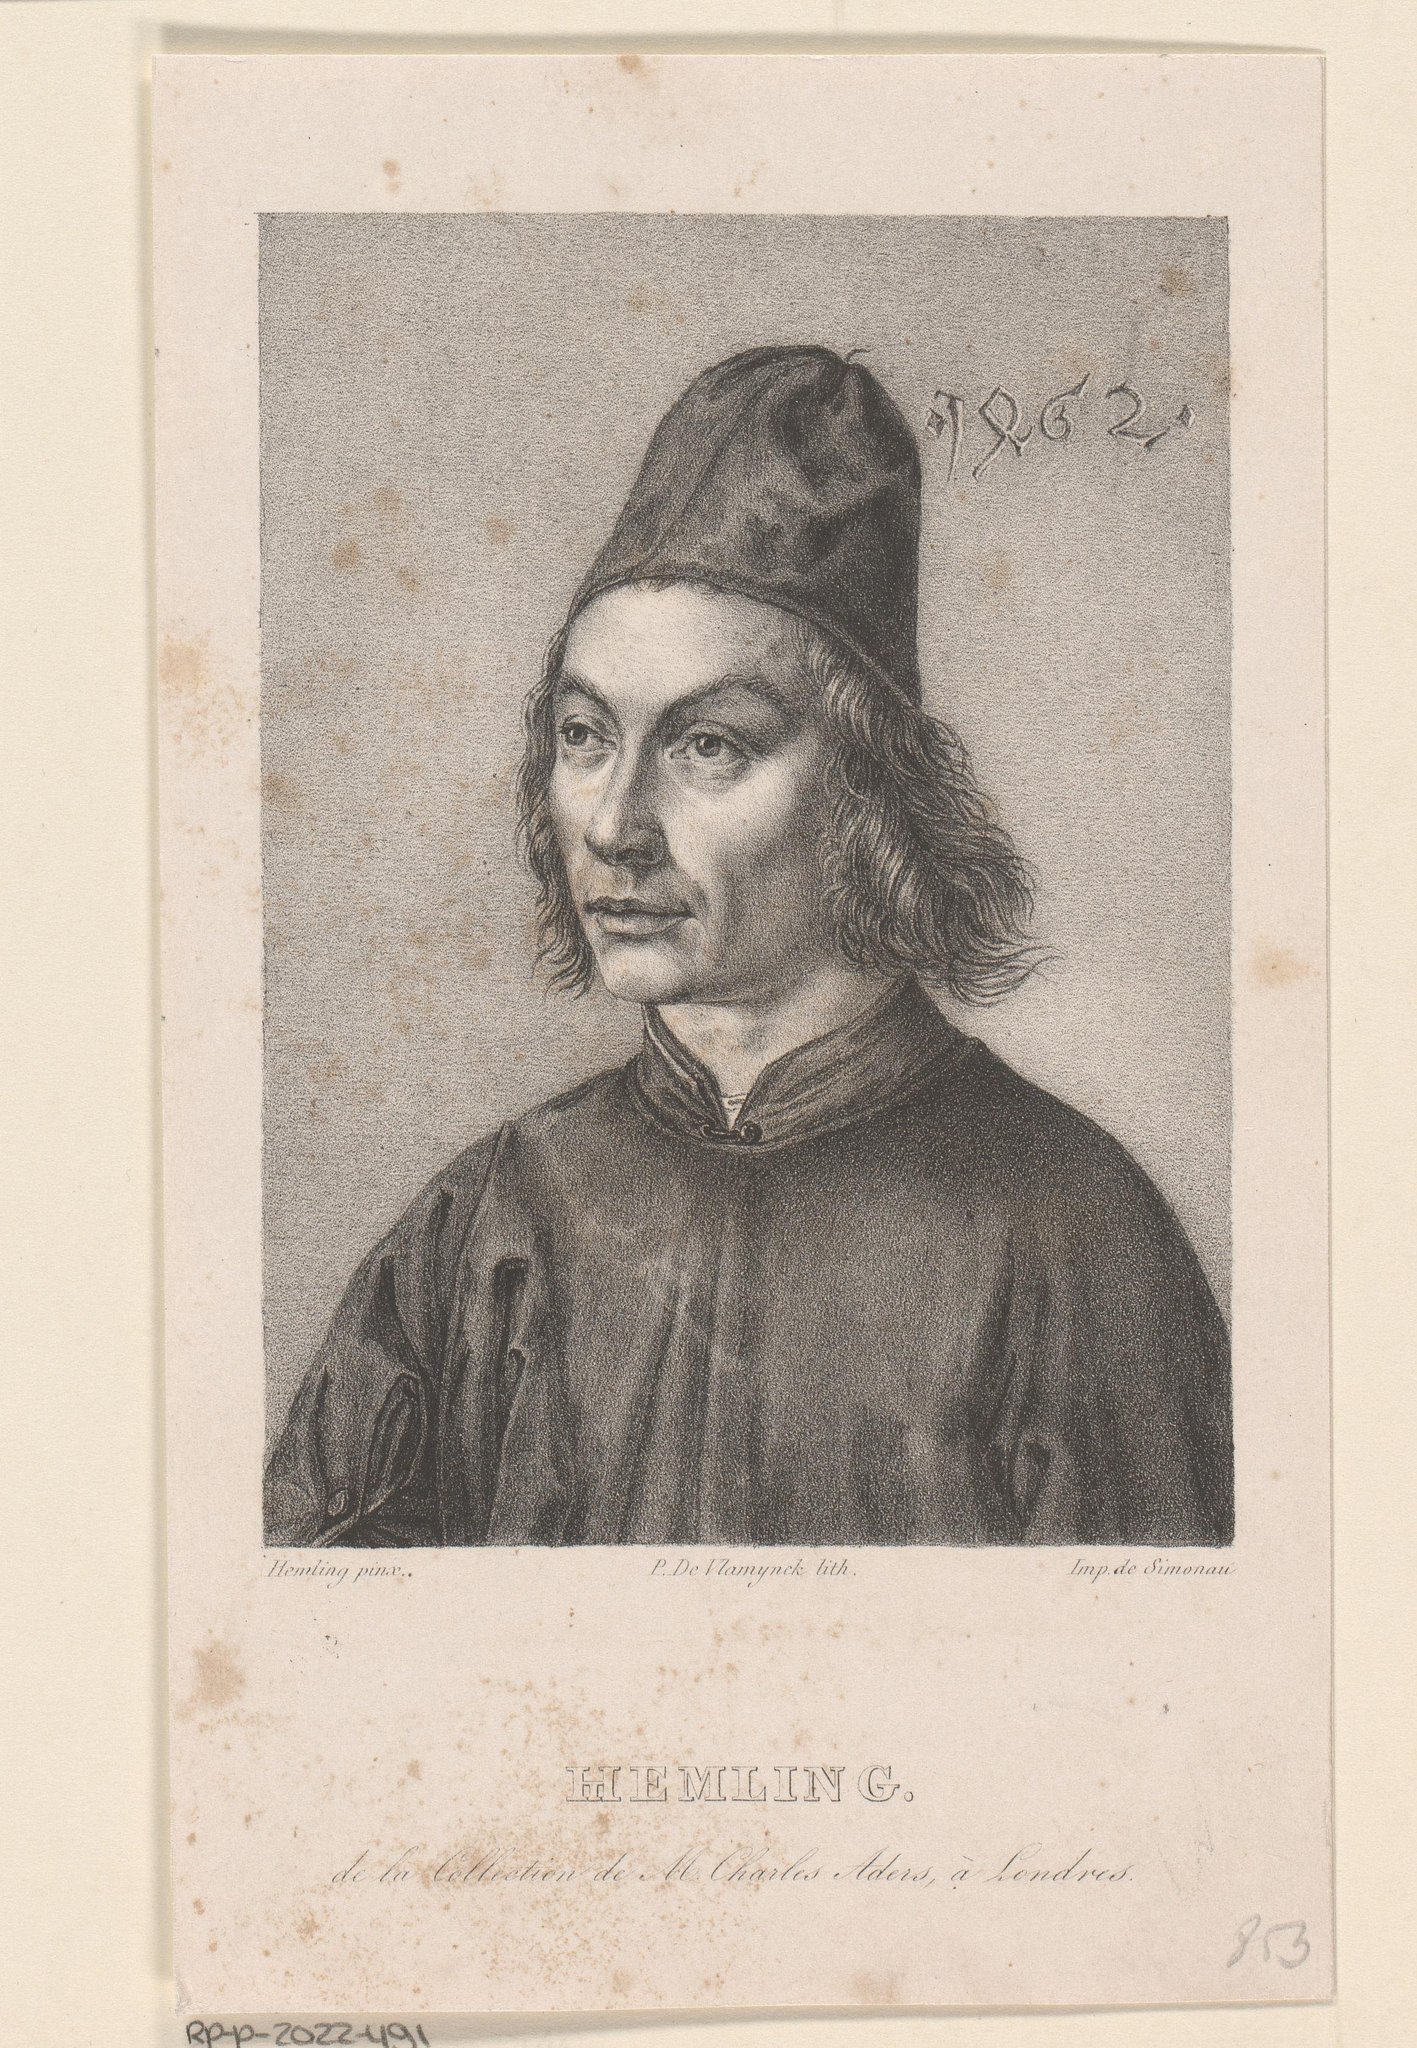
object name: print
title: Memling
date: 1820-1870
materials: paper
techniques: lithograph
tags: bruges, painter, draughtsman, hans memling, historical persons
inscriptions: number: ‘853’, collector's mark: Lugt 2228, collector's mark: Lugt 2760